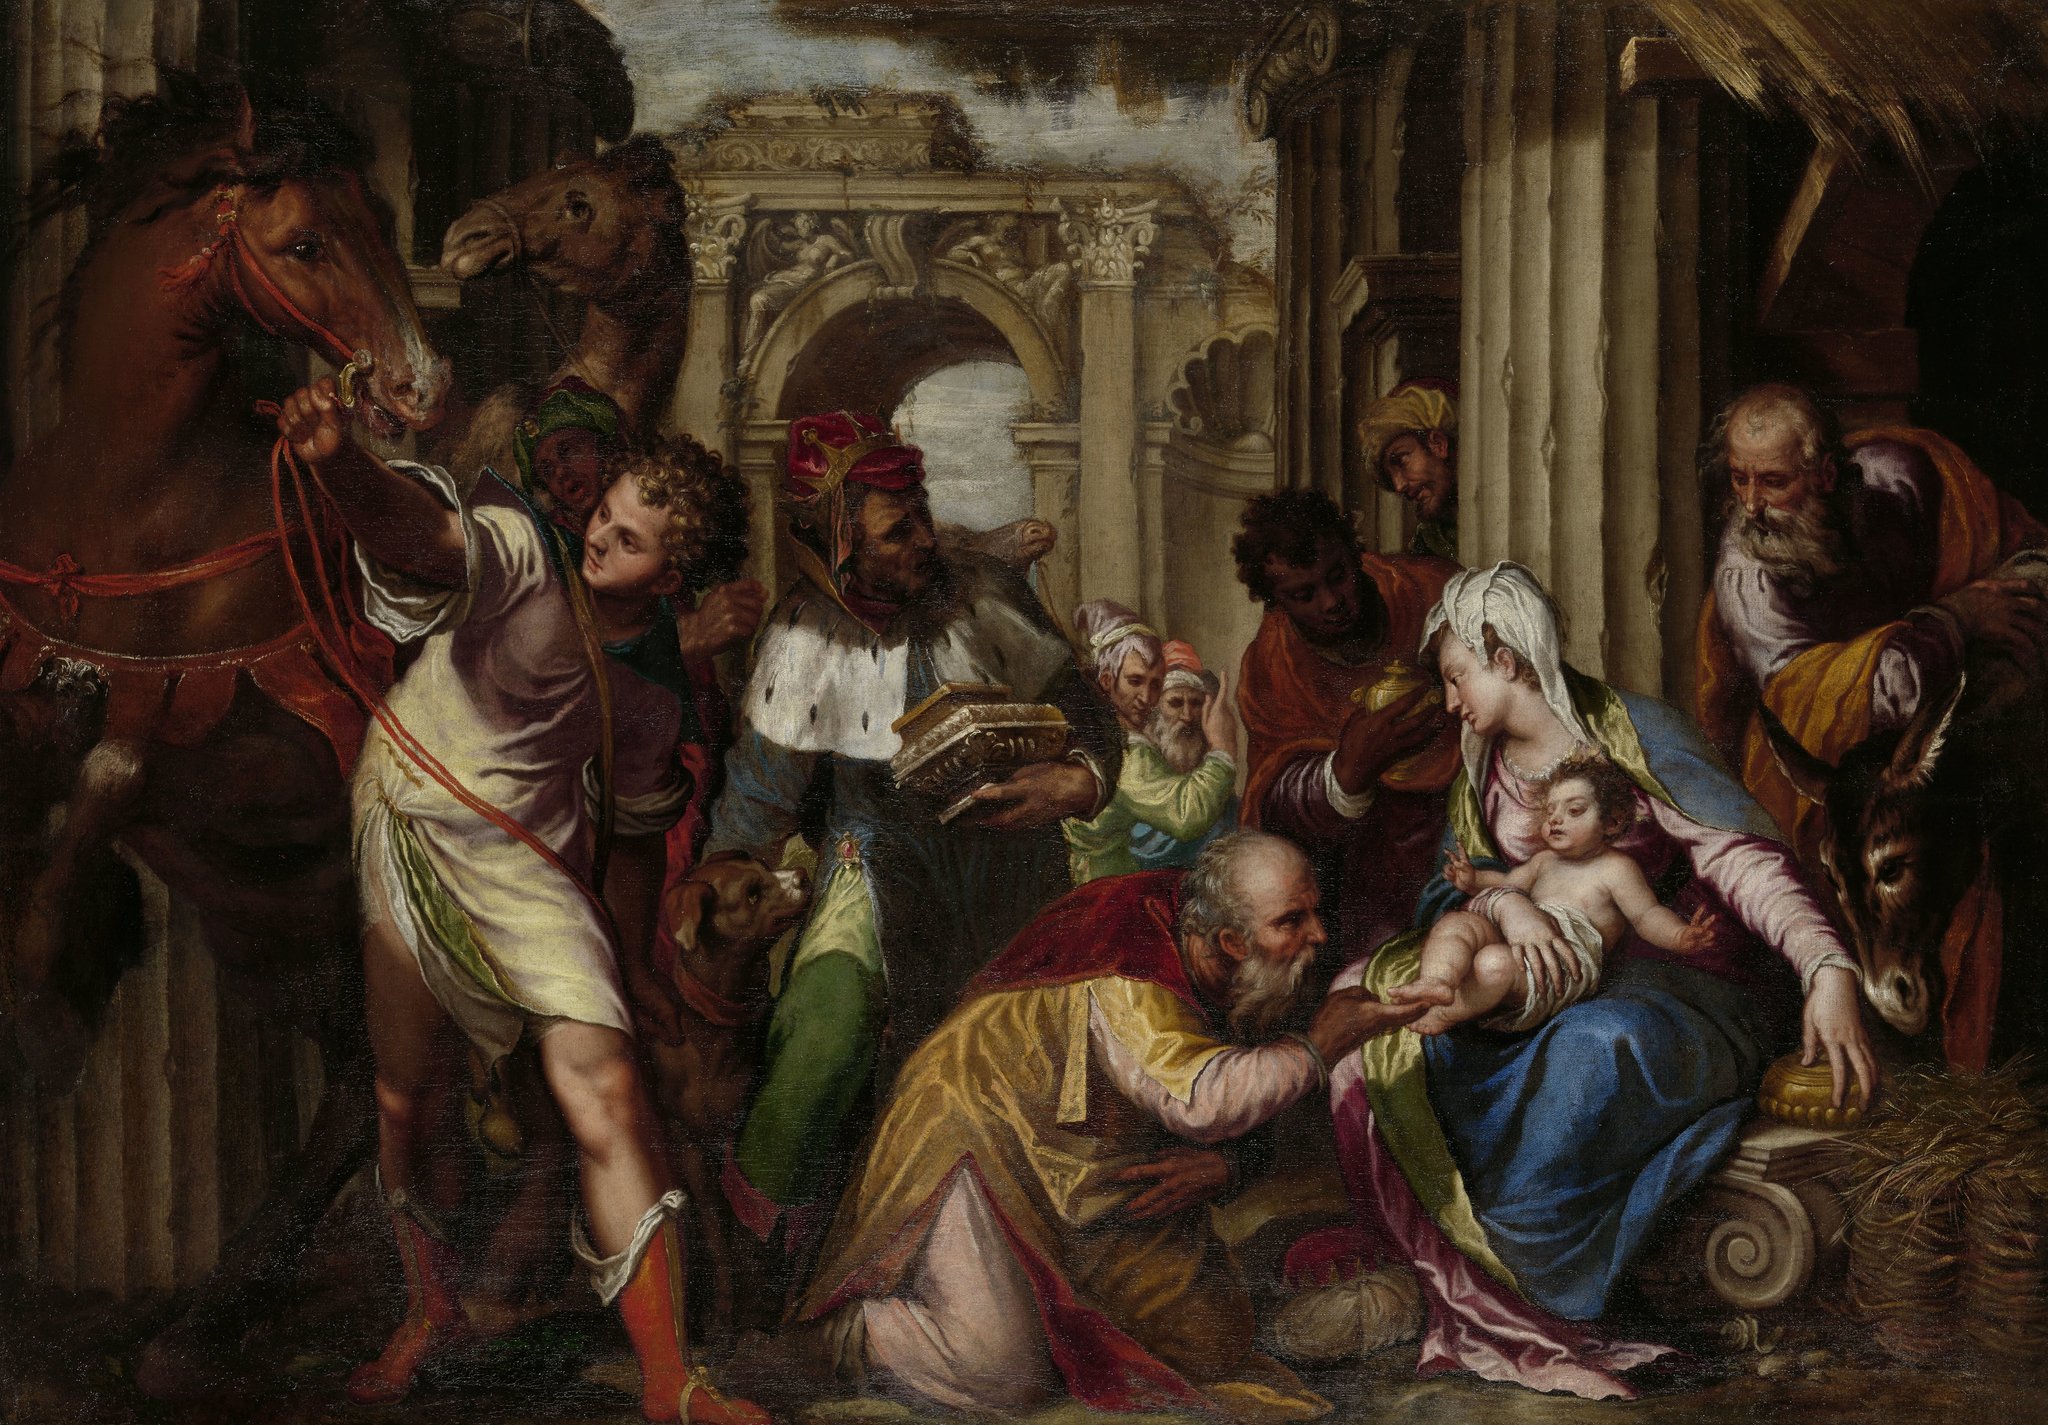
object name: painting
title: The Adoration of the Magi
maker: paolo farinati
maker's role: painter, print maker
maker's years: 1524-1606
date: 1585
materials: canvas, oil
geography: verona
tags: adoration of the kings: the wise men present their gifts to the christ-child (gold, frankincense and myrrh)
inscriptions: signature: ‘een slak of slakkenhuis’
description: Farinati was the leading painter of Verona, Italy, and in his day as famous as Tintoretto and Veronese. He devised this dramatic composition around 1565, and later painted several more versions of it. The gestures of the crowded figures – such as the extended arm of the young man at the left – contribute to the picture’s dynamism. Jesus catches the attention of all gathered round, even the ass.